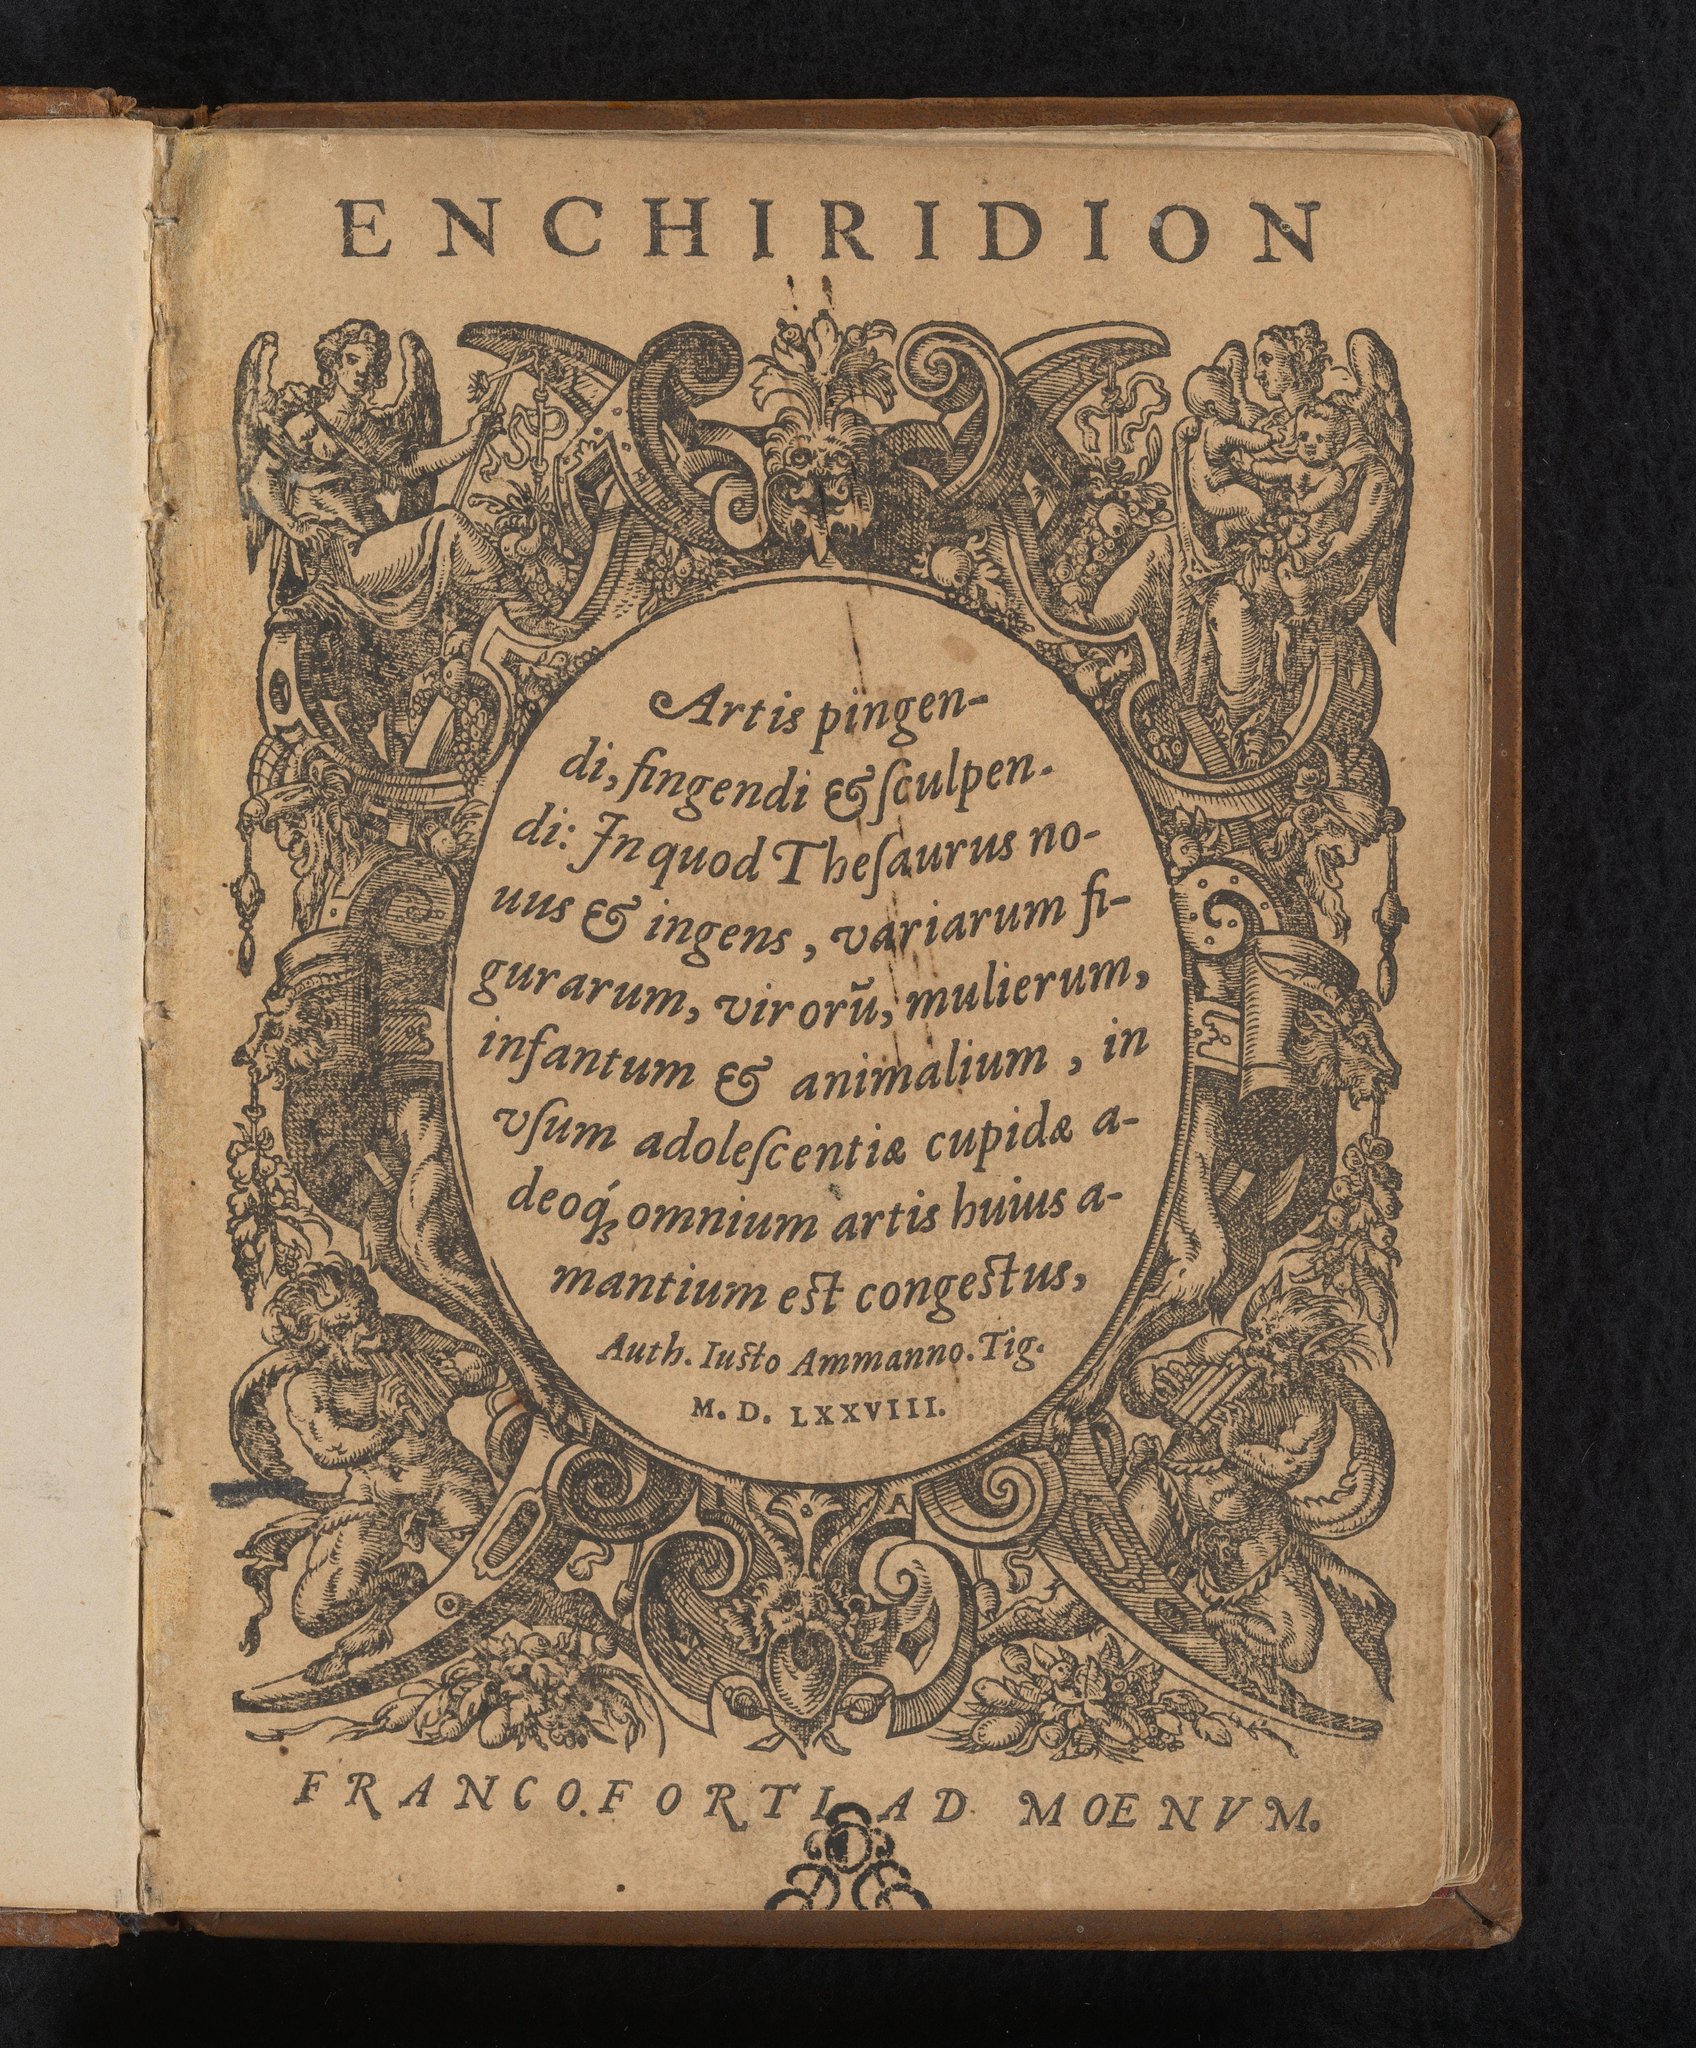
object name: print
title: Titelprent met de titel 'Enchiridion artis pingendi' in boekdruk in een ovaal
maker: jost amman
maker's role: draughtsman, painter, print maker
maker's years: 1539-1591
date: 1578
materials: paper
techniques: letterpress printing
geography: nuremberg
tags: ornaments ~ art, panpipes, satyrs, fauns, sileni, mask, mascaron ~ ornament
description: Titelprent met de titel in boekdruk in een ovaal binnen een kader van allegorische vrouwenfiguren, saters met panfluiten, mascarons, fruit en rolwerk. Onderdeel van het modelboek Enchiridion artis pingendi, fingendi & sculpendi met 108 figuren bedoeld voor beginnende schilders, beeldhouwers en prentmakers.